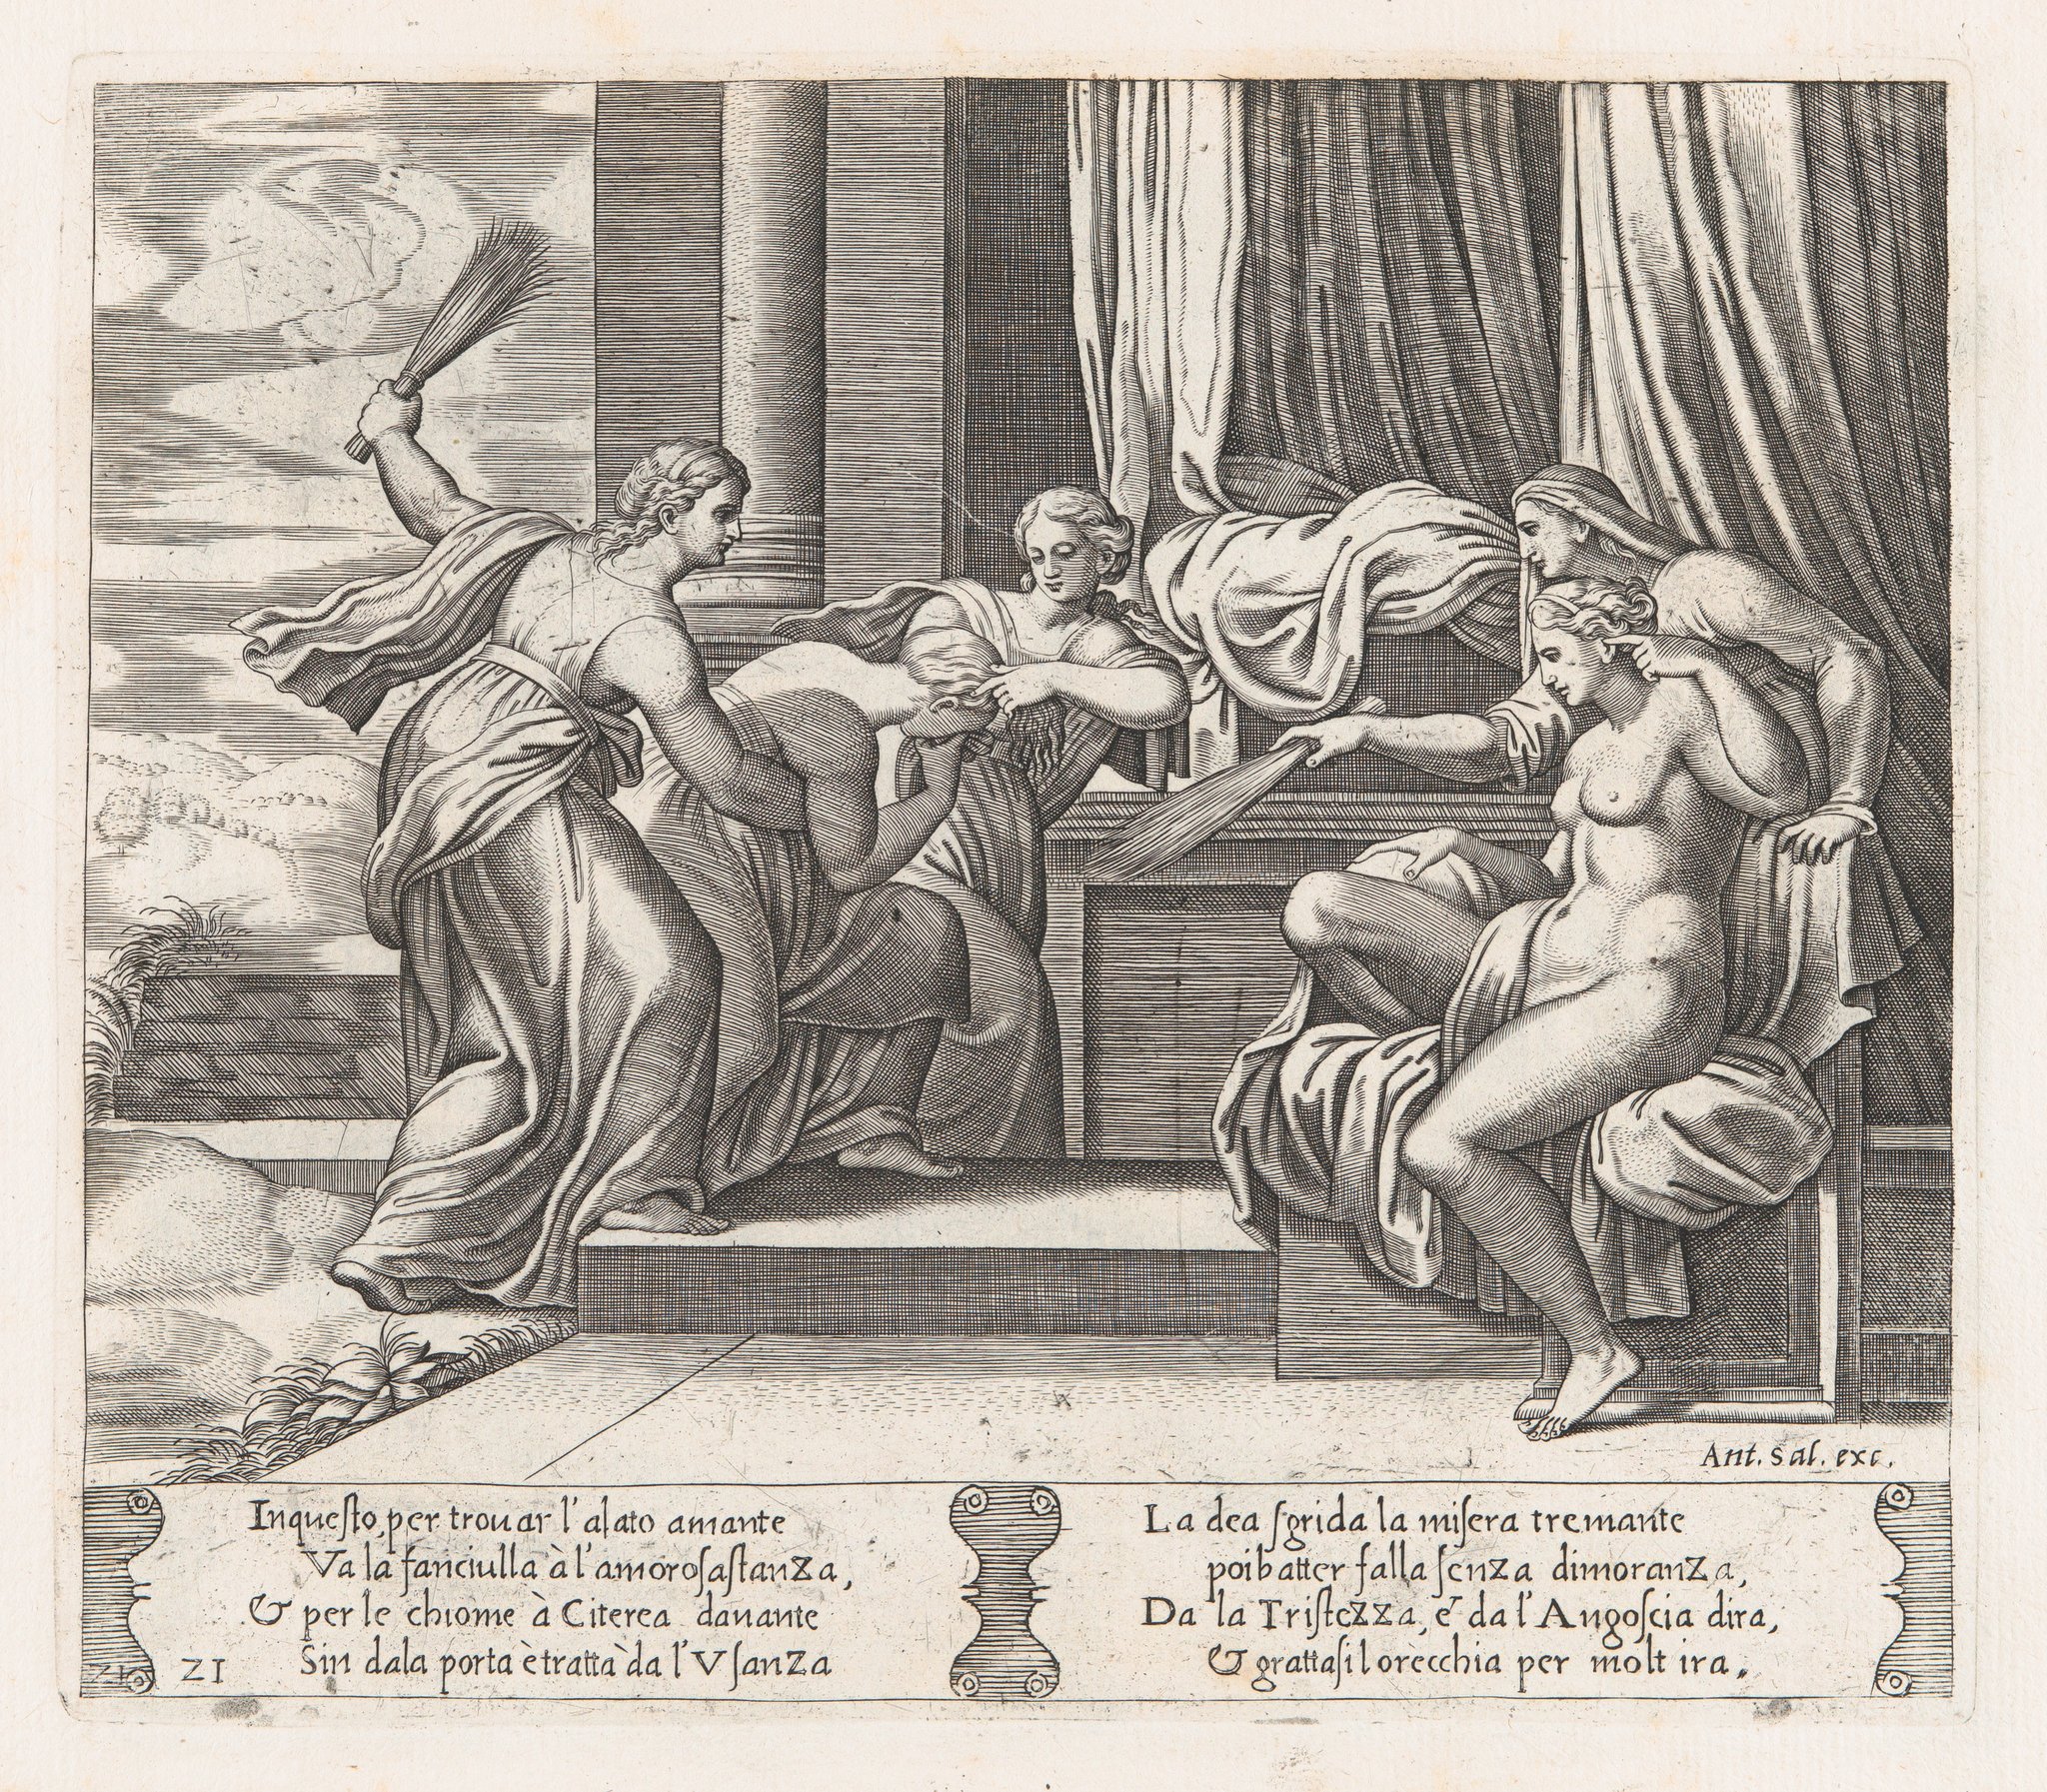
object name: print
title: Plate 21: Female personifications of Sorrow and Pain at right punishing Psyche at the behest of Venus, who sits at right, from "The Story of Cupid and Psyche as told by Apuleius"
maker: master of the die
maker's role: artist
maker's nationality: italian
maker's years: 1525-1560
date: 1530-1560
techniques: engraving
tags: women,psyche,venus,punishment